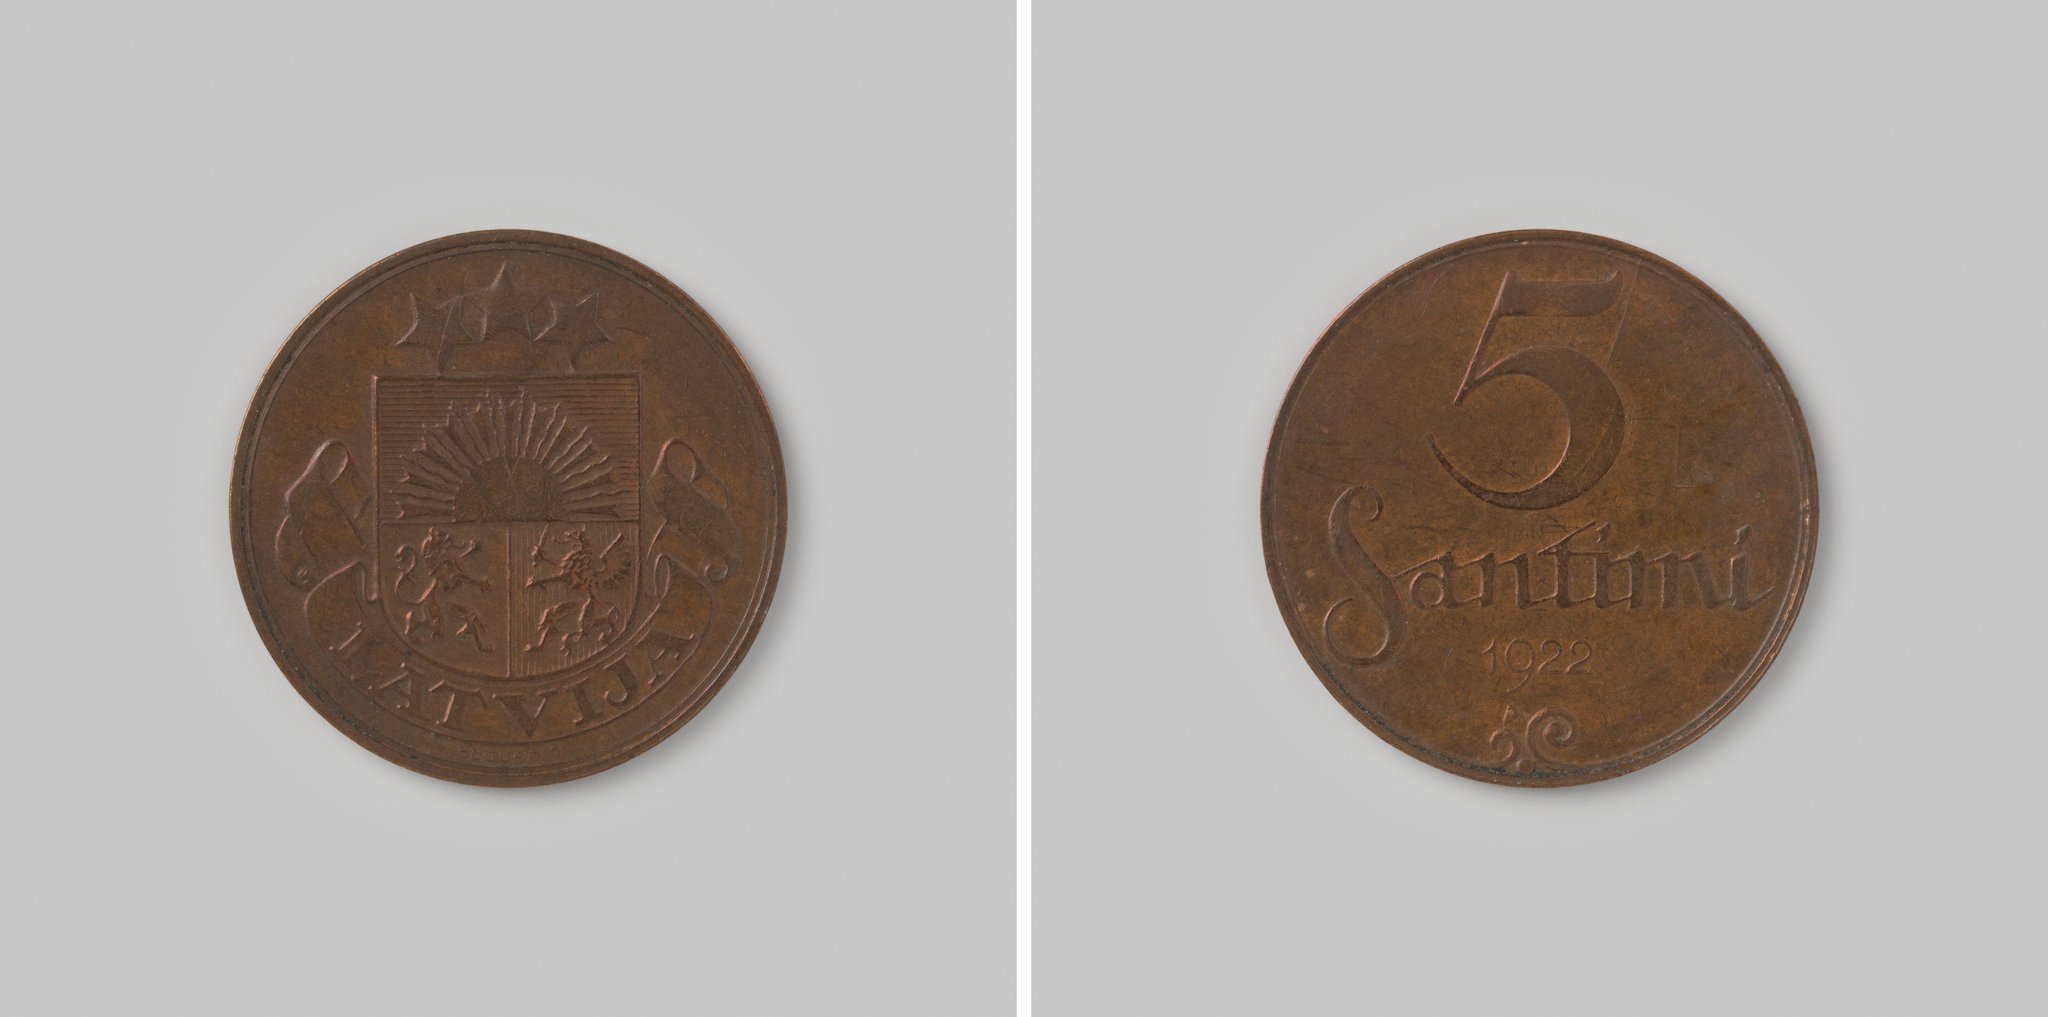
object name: coin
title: Letland, 5 santimi, 1922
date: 1922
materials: bronze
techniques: striking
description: Bronzen munt. Voorzijde: binnen band, waarop lands-aanduiding wapenschild, waarboven drie sterren. Keerzijde: waarde-aanduiding in twee regels, waaronder jaartal. Gladde rand.